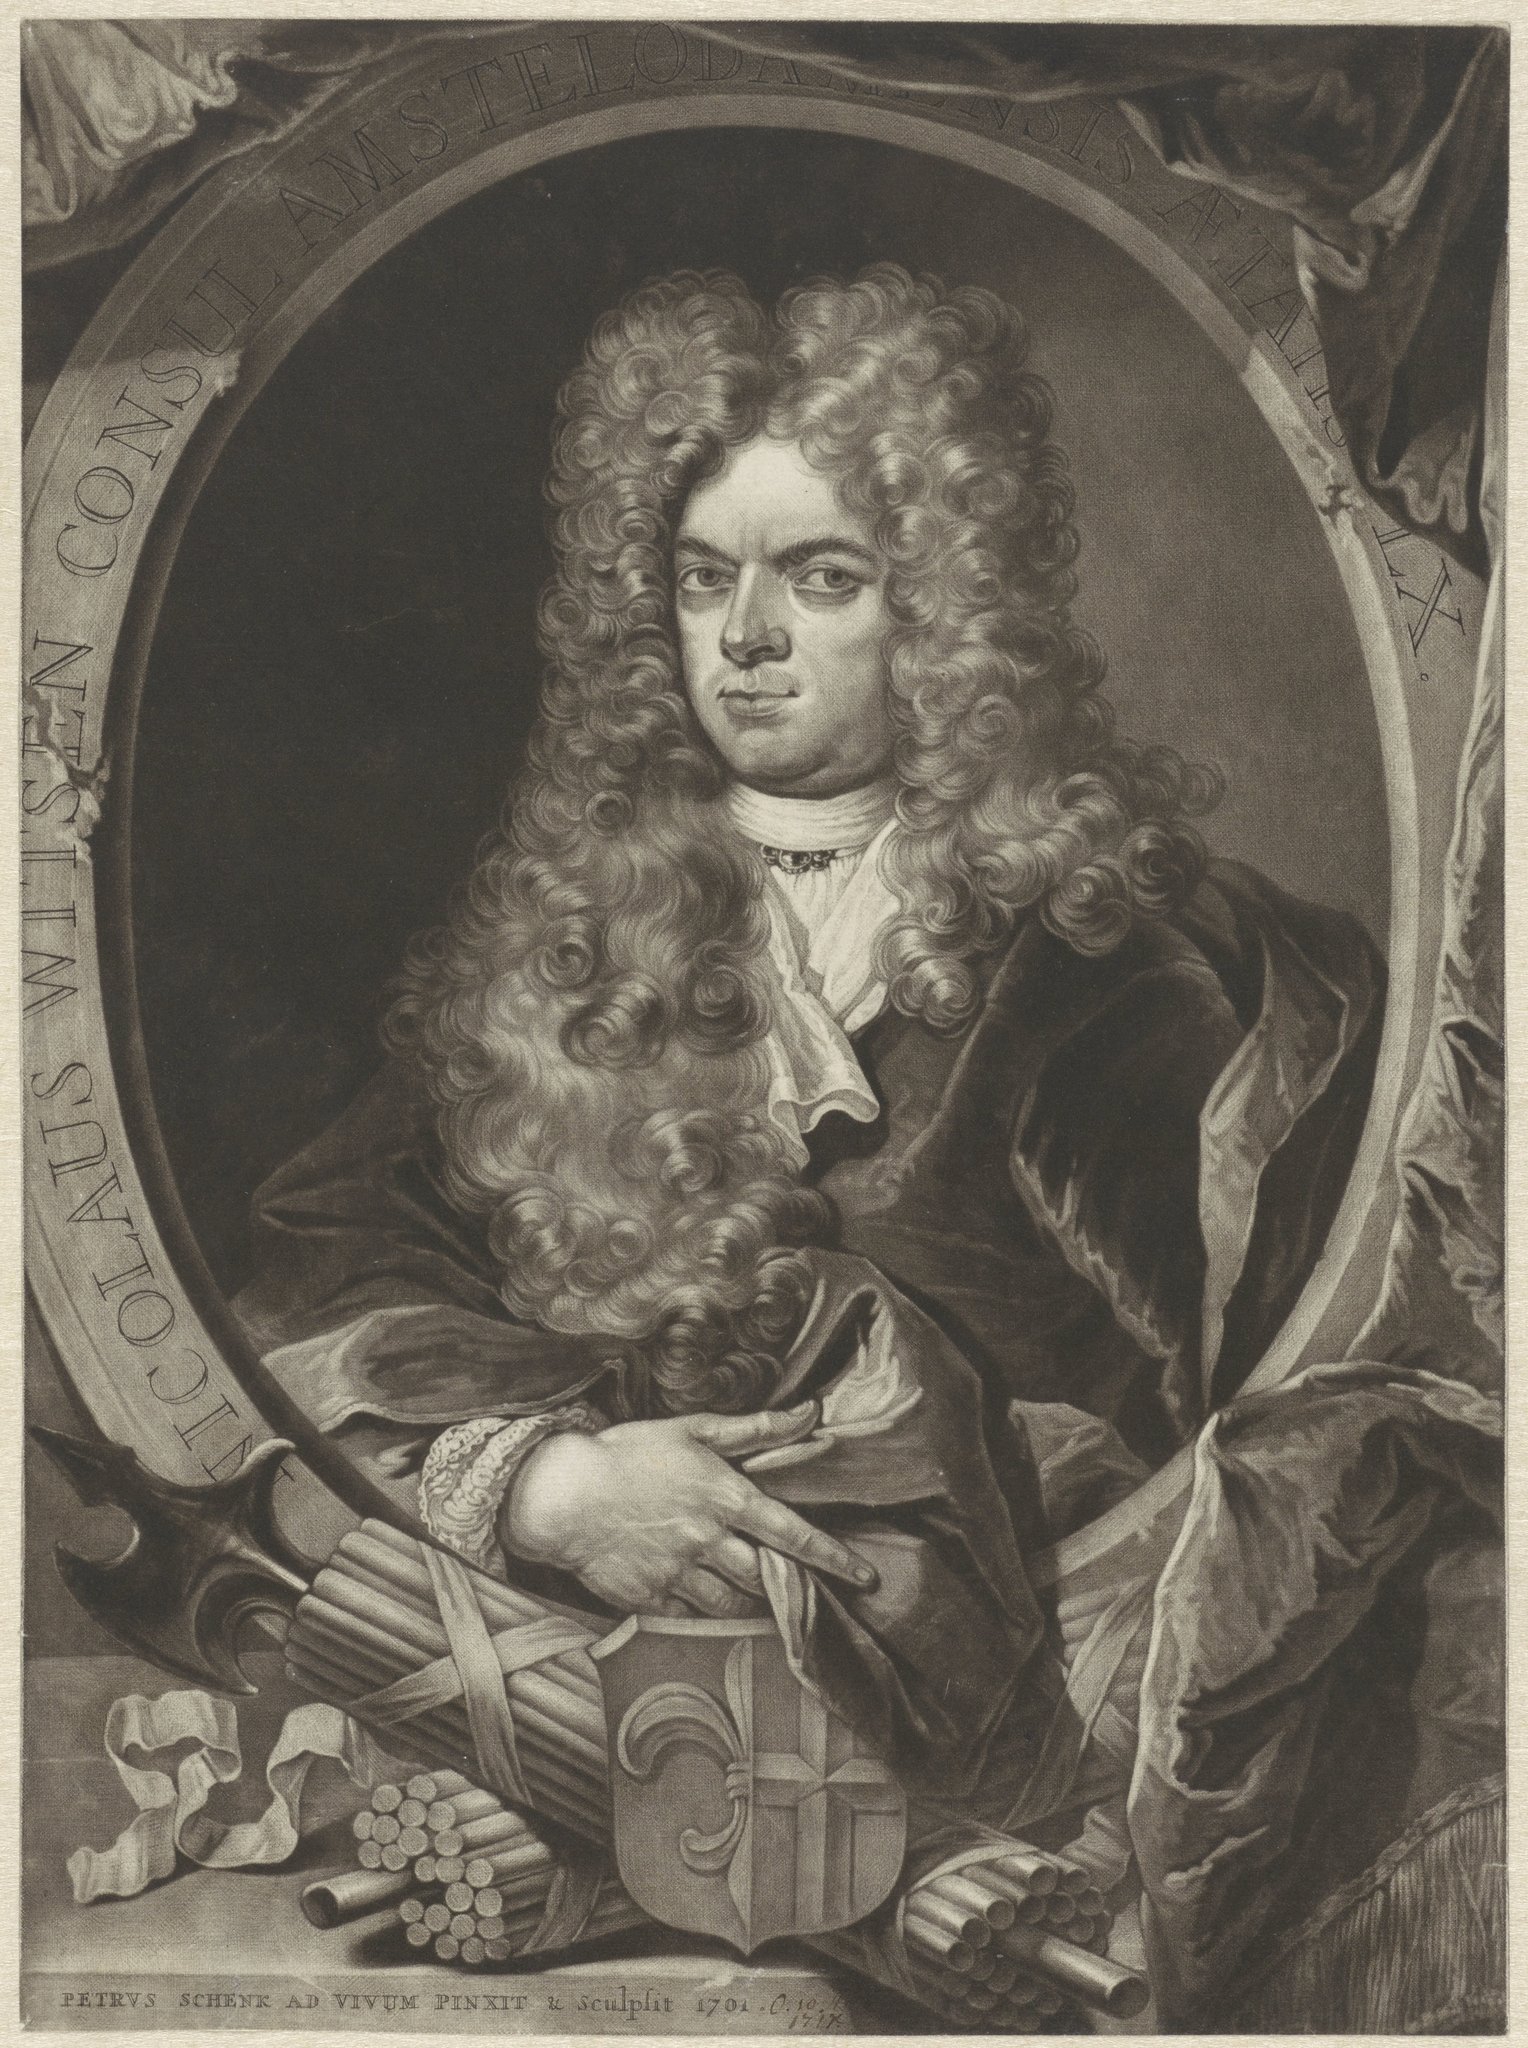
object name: print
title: Portret van Nicolaes Cornelisz. Witsen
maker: pieter schenk (i)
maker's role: print maker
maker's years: 1660-1711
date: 1701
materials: paper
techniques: engraving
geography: amsterdam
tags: amsterdam, print maker, mayor, nicolaes cornelisz. witsen, wig, armorial bearing, heraldry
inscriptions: collector's mark: Lugt 2228, collector's mark: Lugt 2760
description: De prentmaker, cartograaf en burgemeester van Amsterdam, Nicolaes Cornelisz. Witsen op 60-jarige leeftijd. Voor de omlijsting zijn familiewapen en twee fasces.